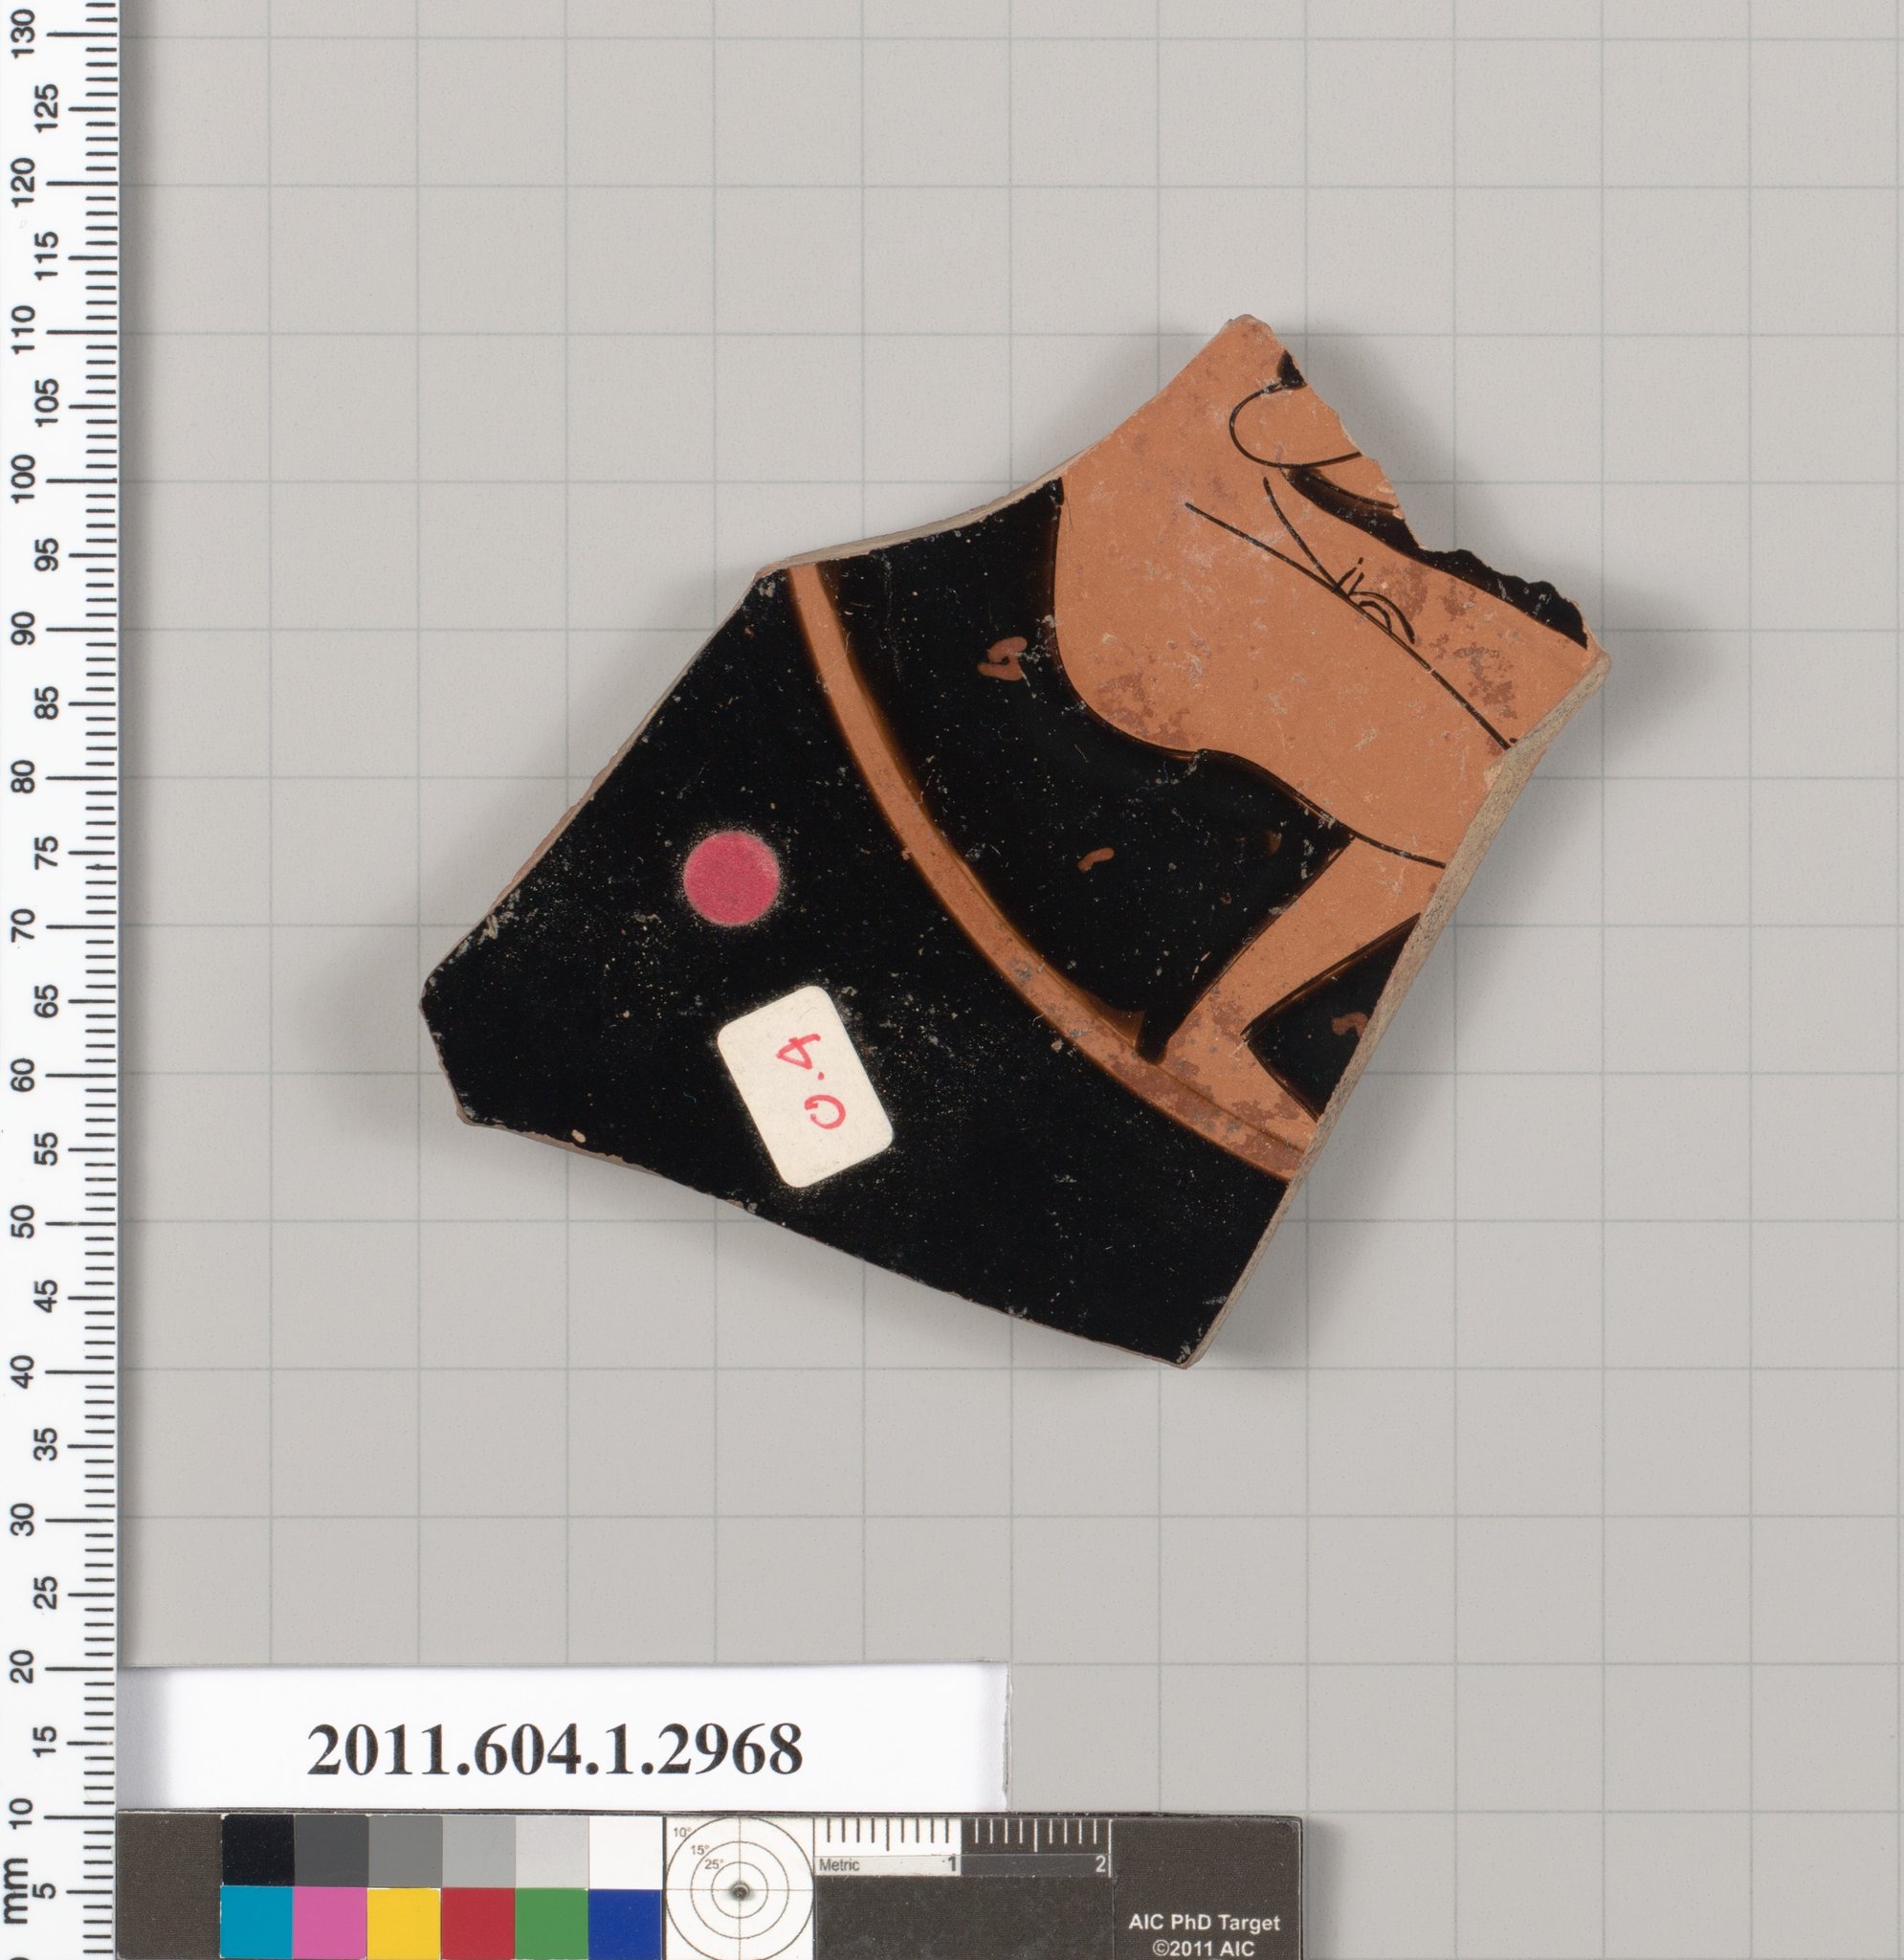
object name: kylix fragment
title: Terracotta fragment of a kylix (drinking cup)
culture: greek, attic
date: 520-500 BCE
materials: terracotta